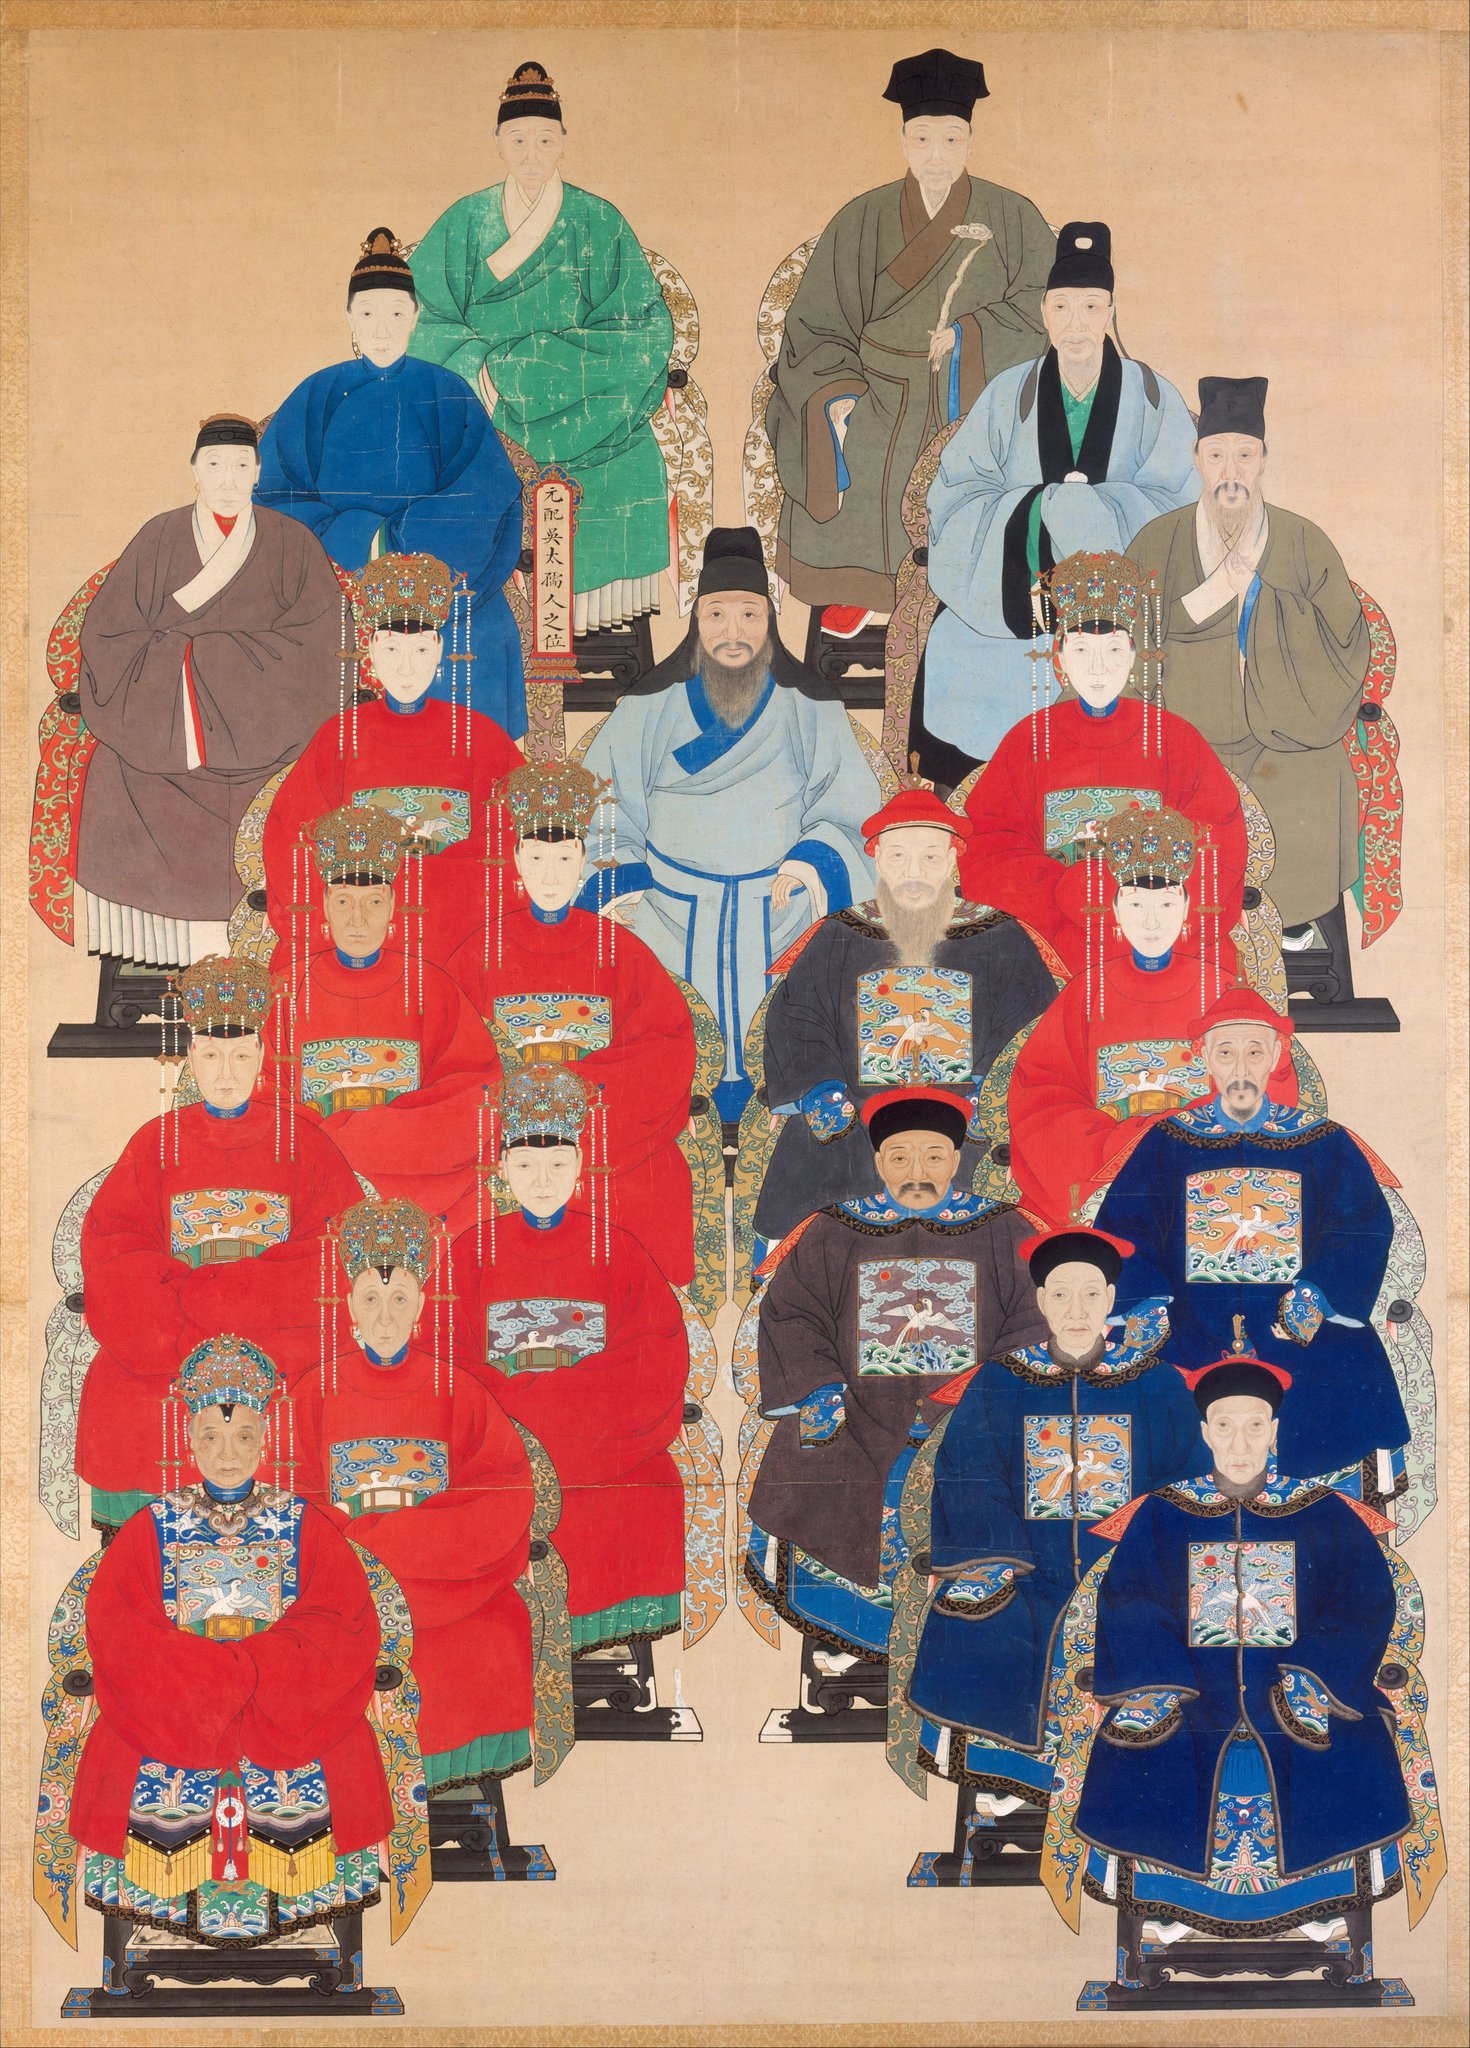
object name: painting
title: Twenty-one Ancestors with Spirit Tablet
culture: chinese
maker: unidentified artist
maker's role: artist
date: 1644-1911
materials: ink, paper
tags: men,women